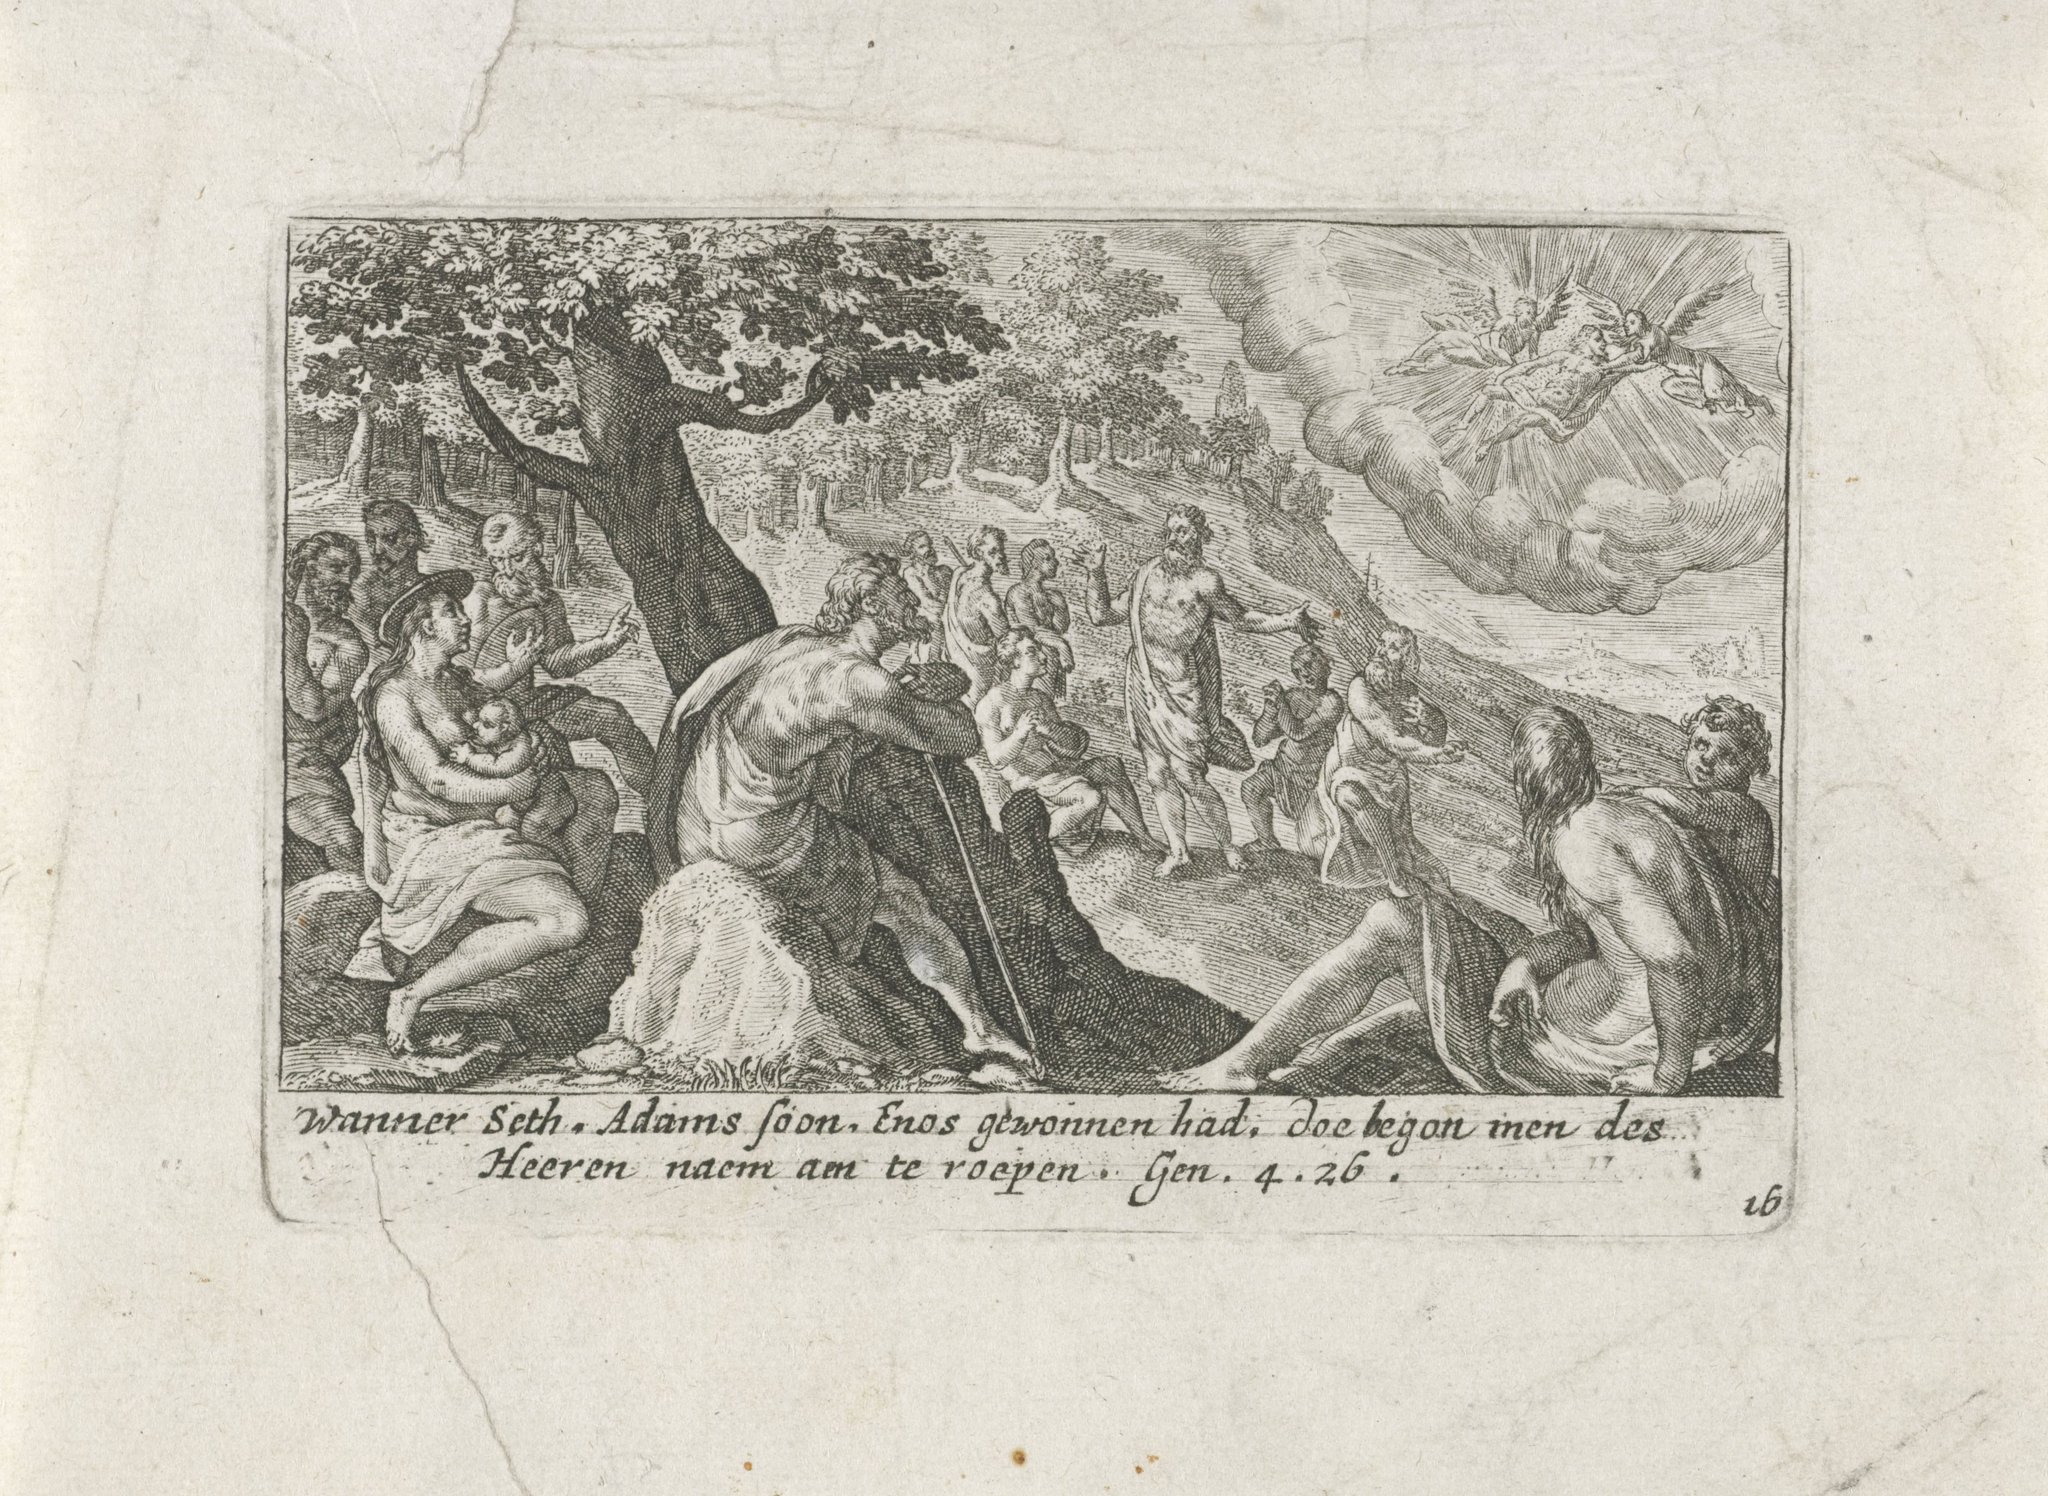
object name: print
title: De mensen roepen God aan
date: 1700-1750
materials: paper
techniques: engraving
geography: utrecht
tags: story of enos (+ god the father)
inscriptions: collector's mark: Lugt 2233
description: Toen Set een zoon kreeg, die hij Enos noemde begon men de naam van God aan te roepen. In de marge een tweeregelig onderschrift in het Nederlands.